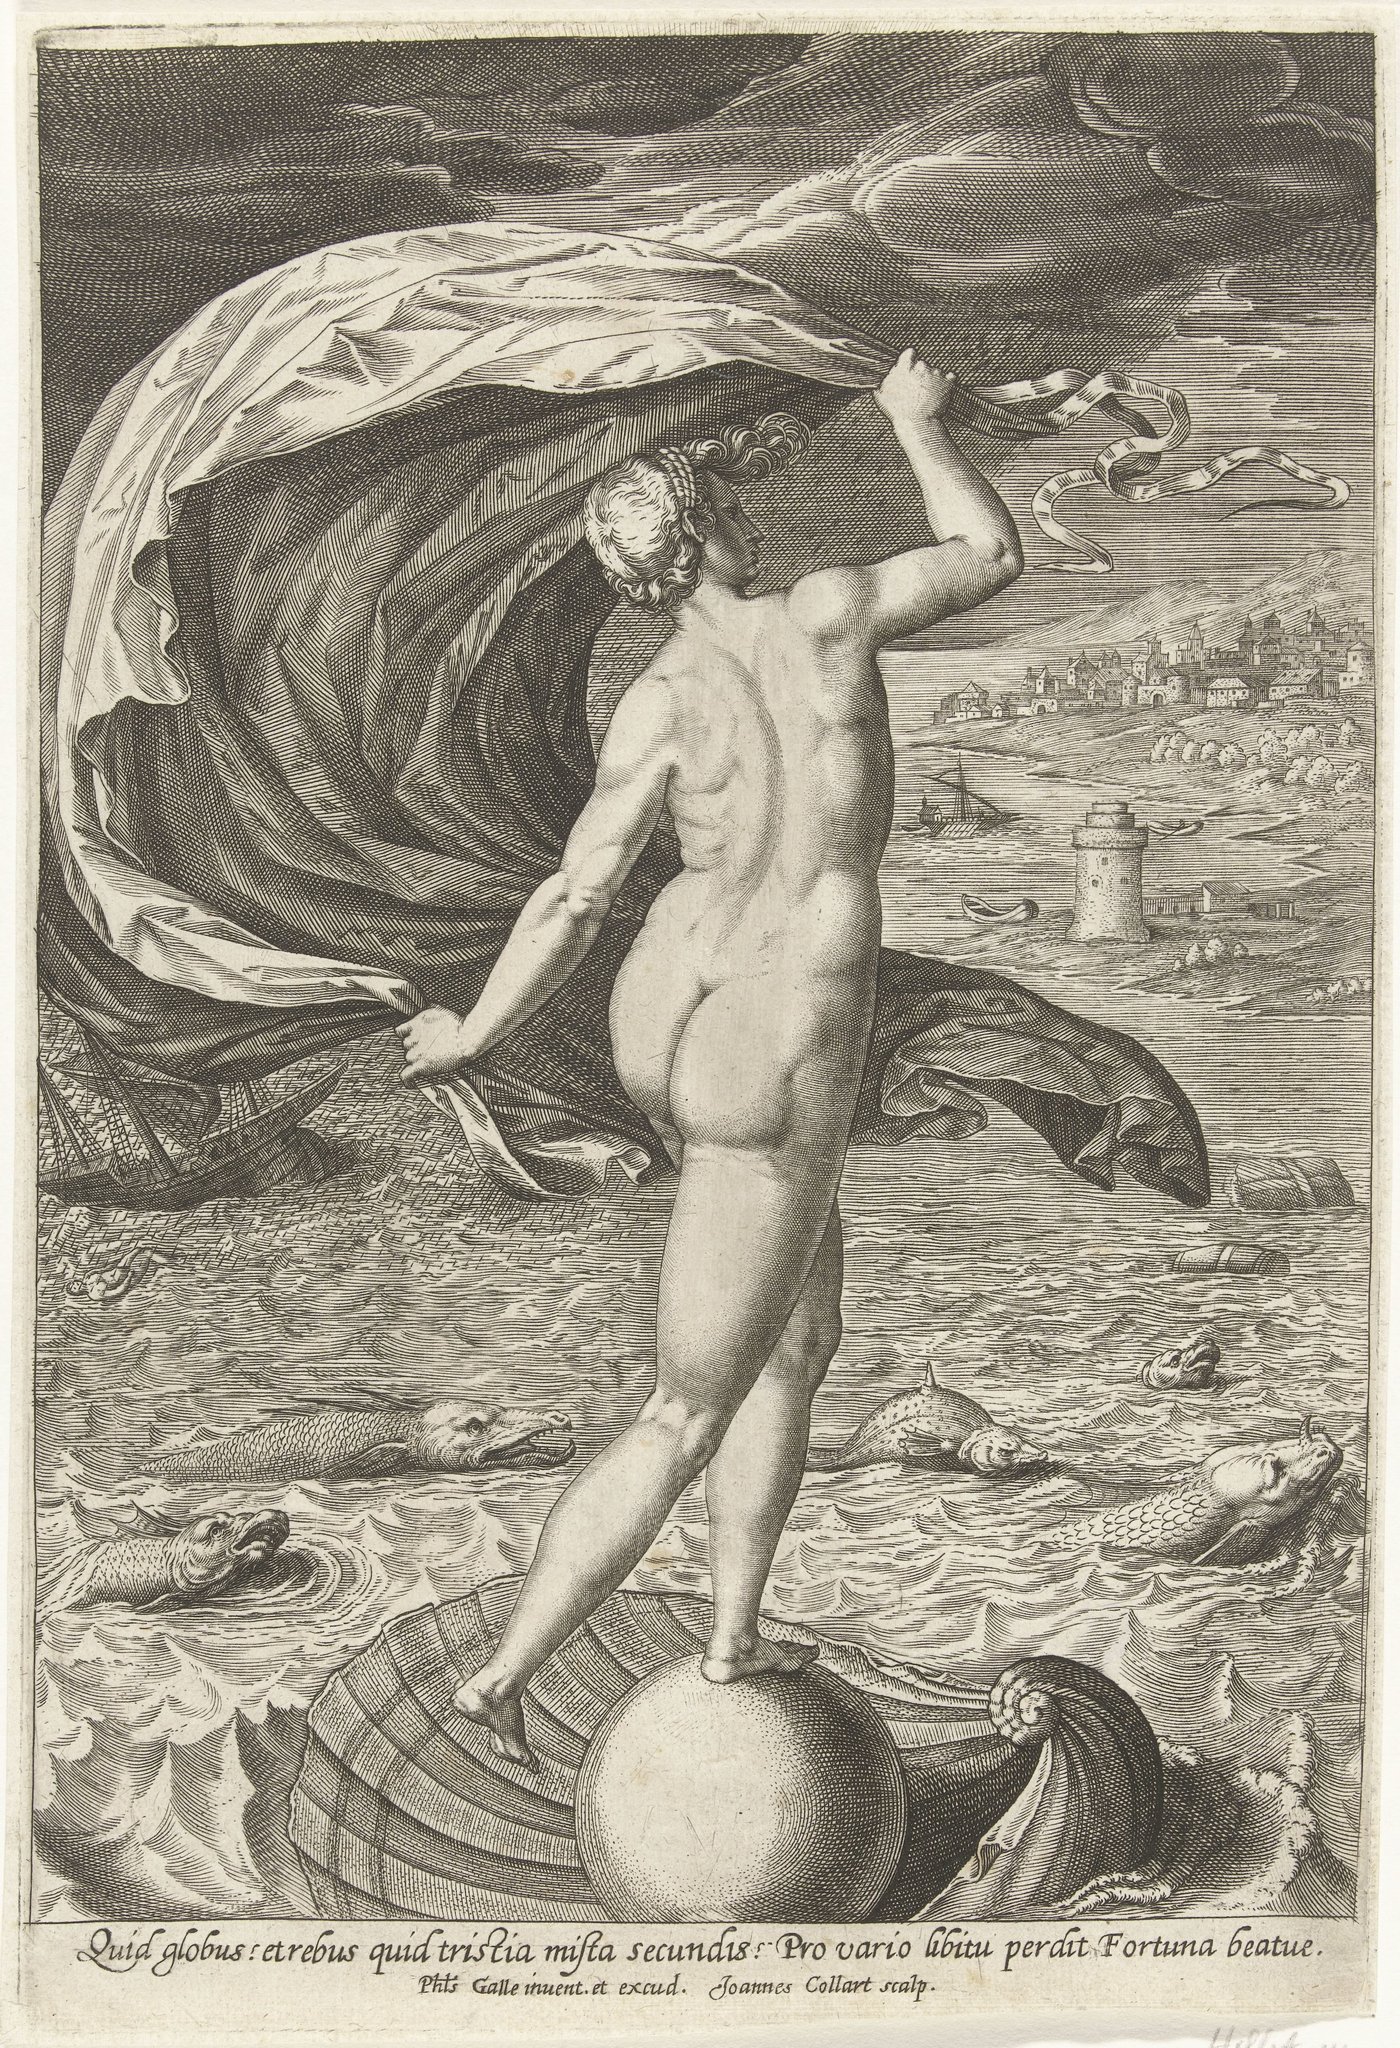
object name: print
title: Fortuin (Fortuna)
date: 1576-1628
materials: paper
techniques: engraving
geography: antwerp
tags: city-view in general; 'veduta', shipwreck, luck, fortune, lot; 'fato', 'fortuna', 'fortuna aurea', 'fortuna buona', 'fortuna pacifica overo clemente', 'sorte' (ripa)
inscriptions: collector's mark: Lugt 2166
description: De naakte personificatie van Fortuin of Geluk (Fortuna) vaart op een schelp over zee. Ze staat op een globe, teken van de wisselvalligheid van het geluk. Ook het bolle zeil waarmee ze over het water vaart is symbool voor deze wisselvalligheid. Rondom haar zwemmen allerlei zeemonsters en gaat een schip ten onder. In de achtergrond de contouren van een stad. De prent heeft een Latijns onderschrift.